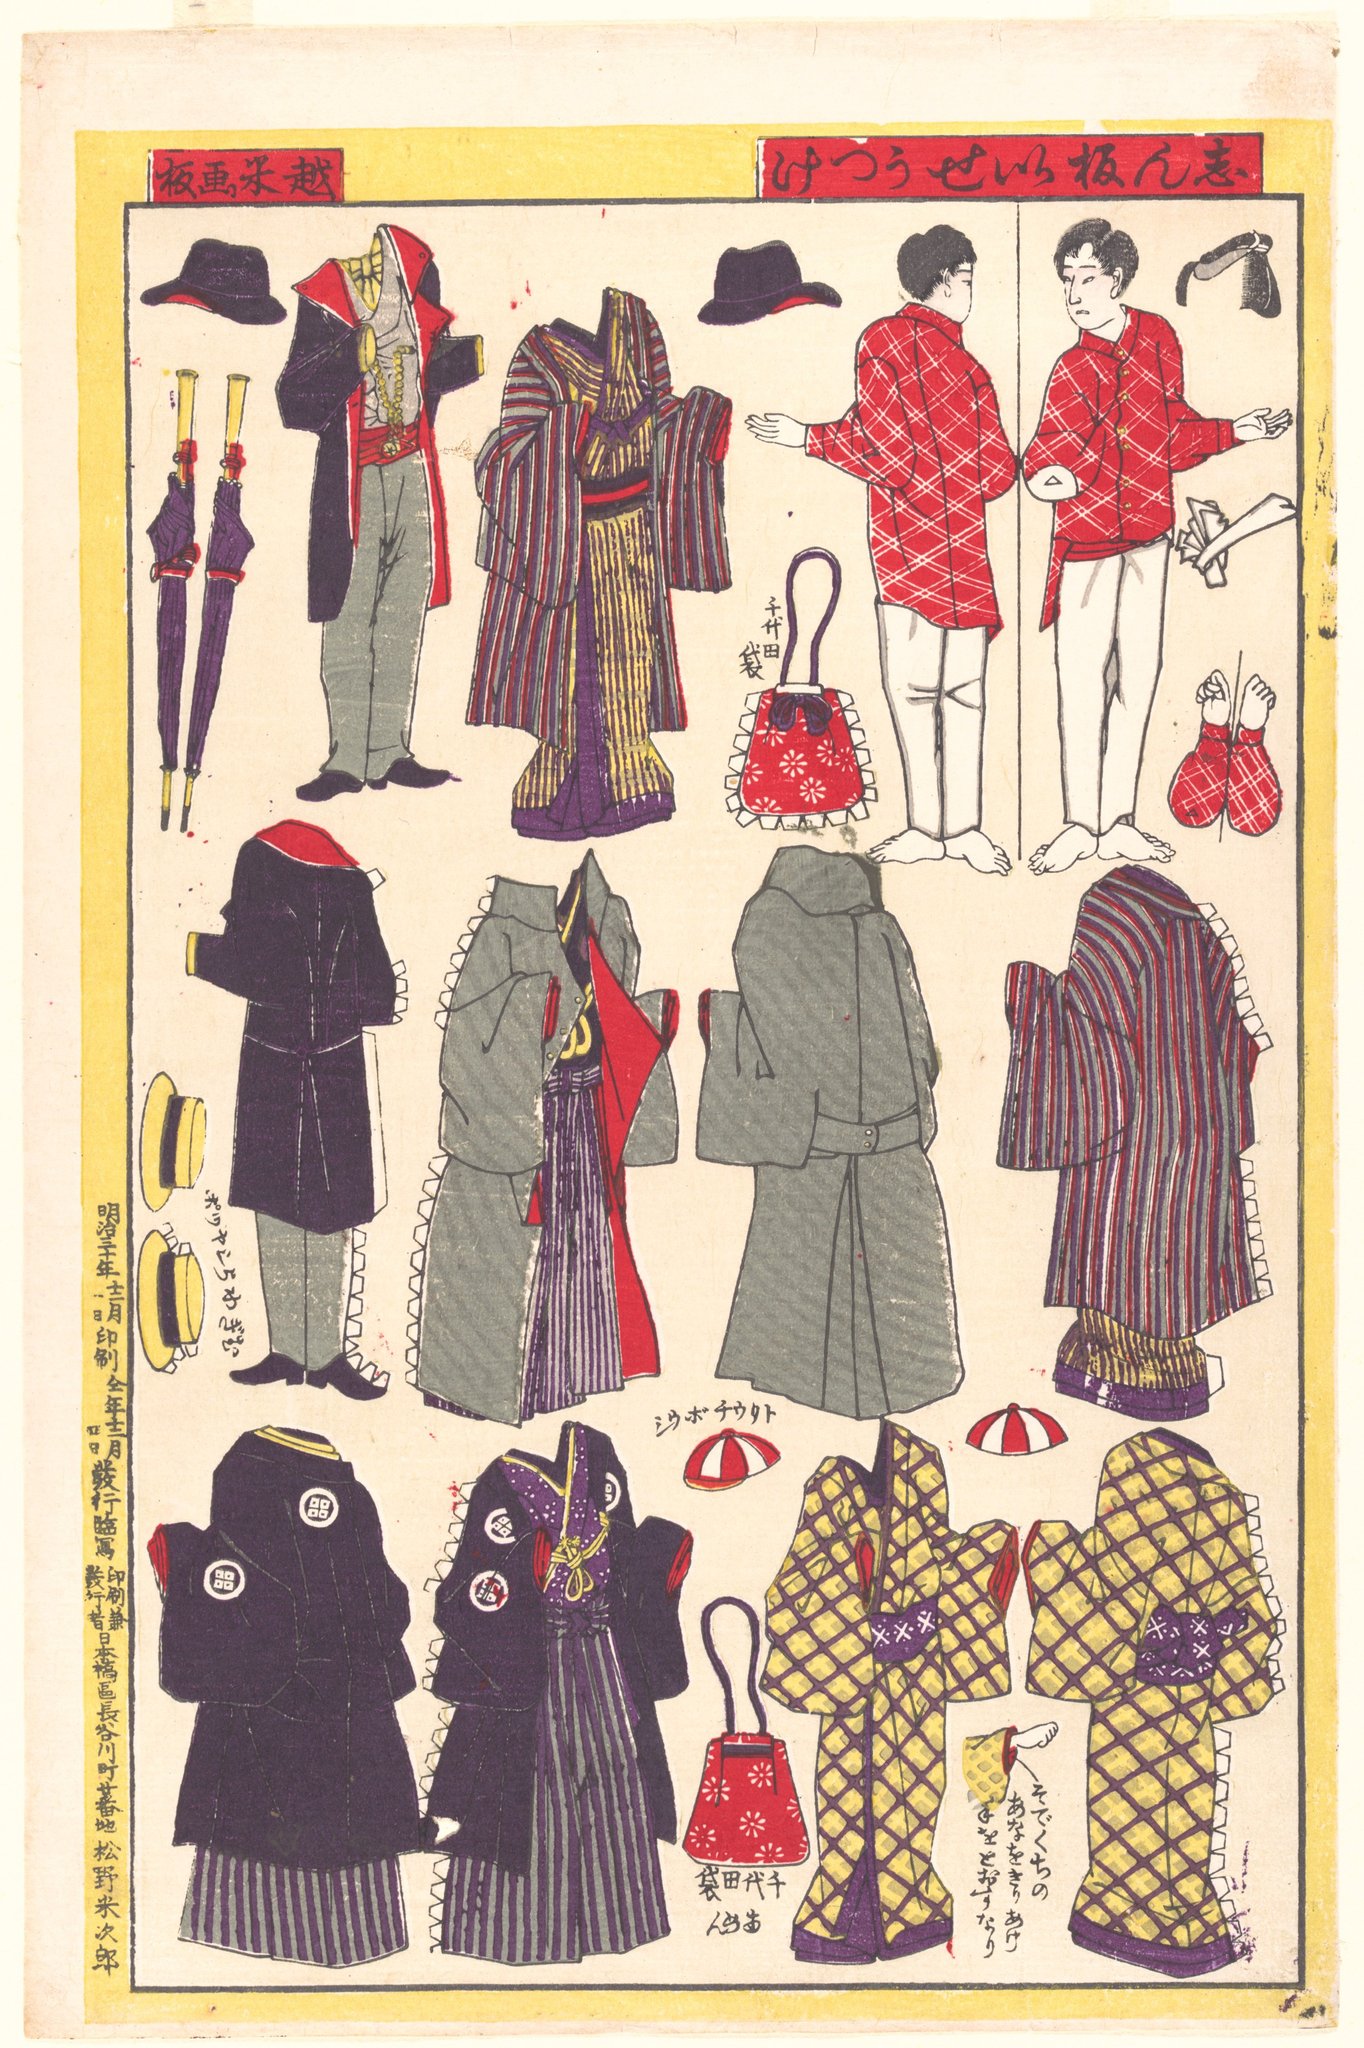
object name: print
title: Paper Doll Clothing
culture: japanese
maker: unidentified artist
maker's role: artist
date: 1897-1898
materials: ink, paper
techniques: nishiki e, woodblock print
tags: dresses